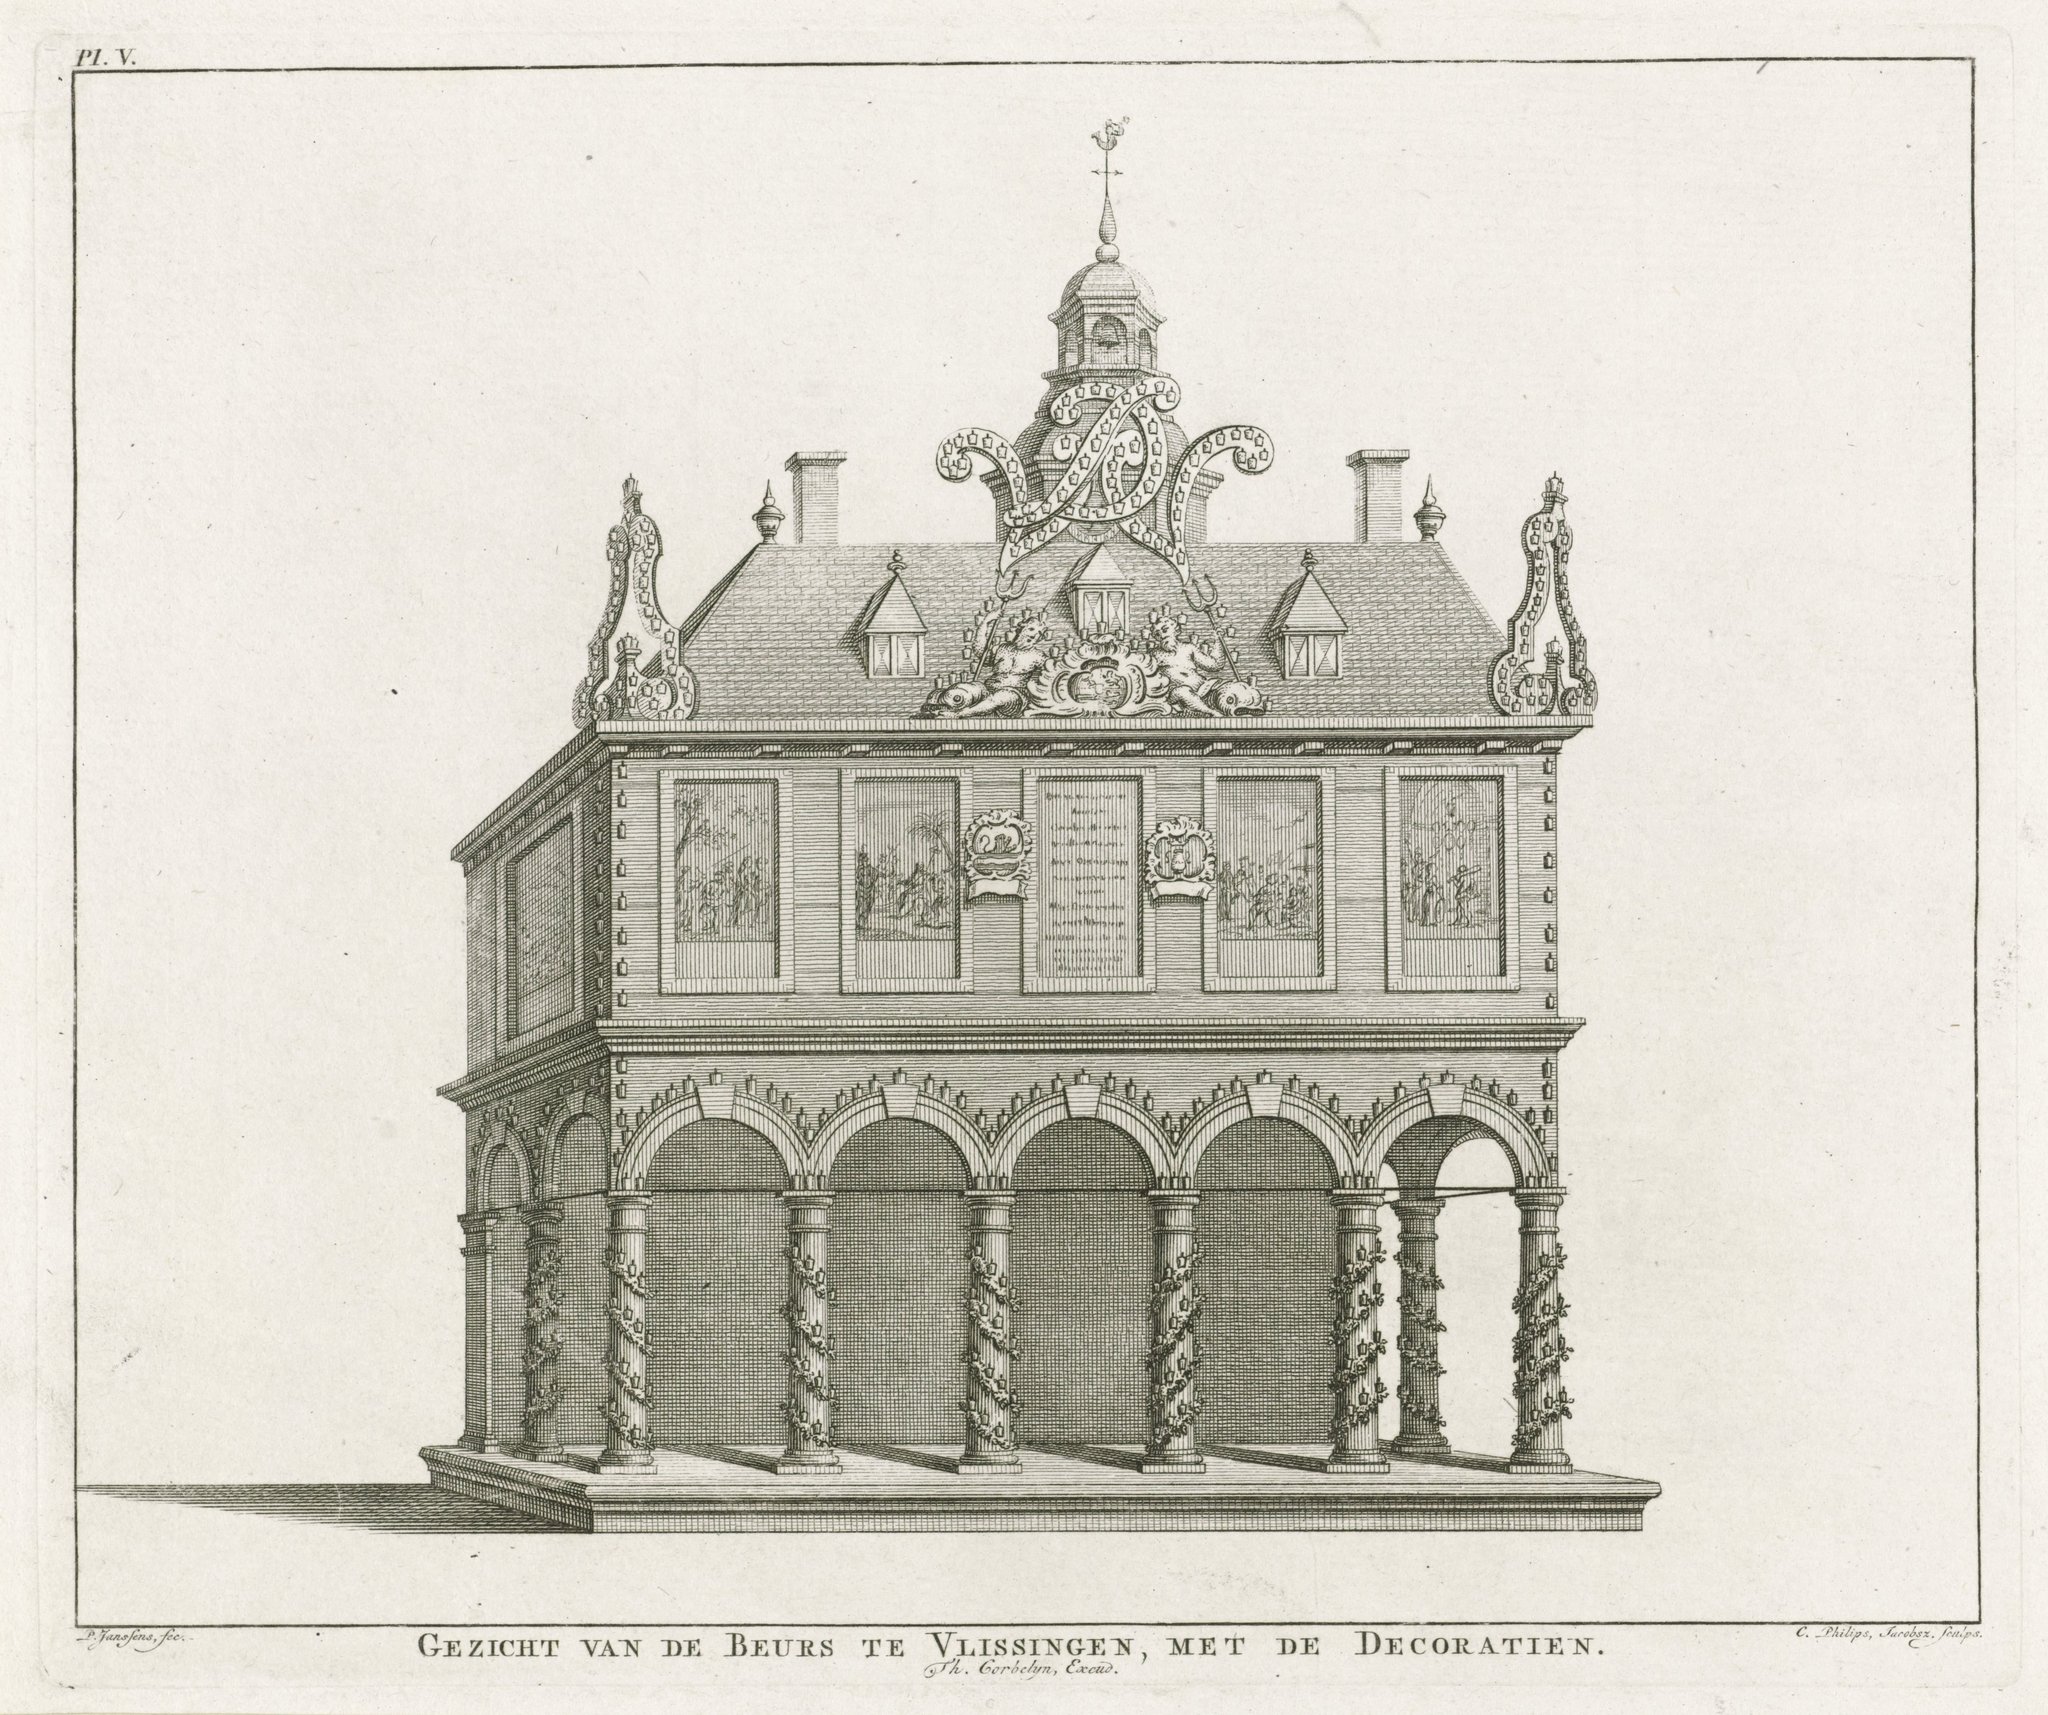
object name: print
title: Gezicht van de Beurs te Vlissingen, met de Decoratien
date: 1772-1773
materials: paper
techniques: engraving, etching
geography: flushing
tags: triumphal entry and public reception, pageant, 'entrée solennelle', 'joyeuse entrée', weigh-house, flushing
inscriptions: collector's mark: Lugt 2228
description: De Beurs te Vlissingen, versierd de viering van 200 jaar vrijheid in Vlissingen, 6 april 1772. Genummerd linksboven: Pl. V. Onderdeel van een groep van negen platen genummerd I-X van de decoraties bij dit feest.